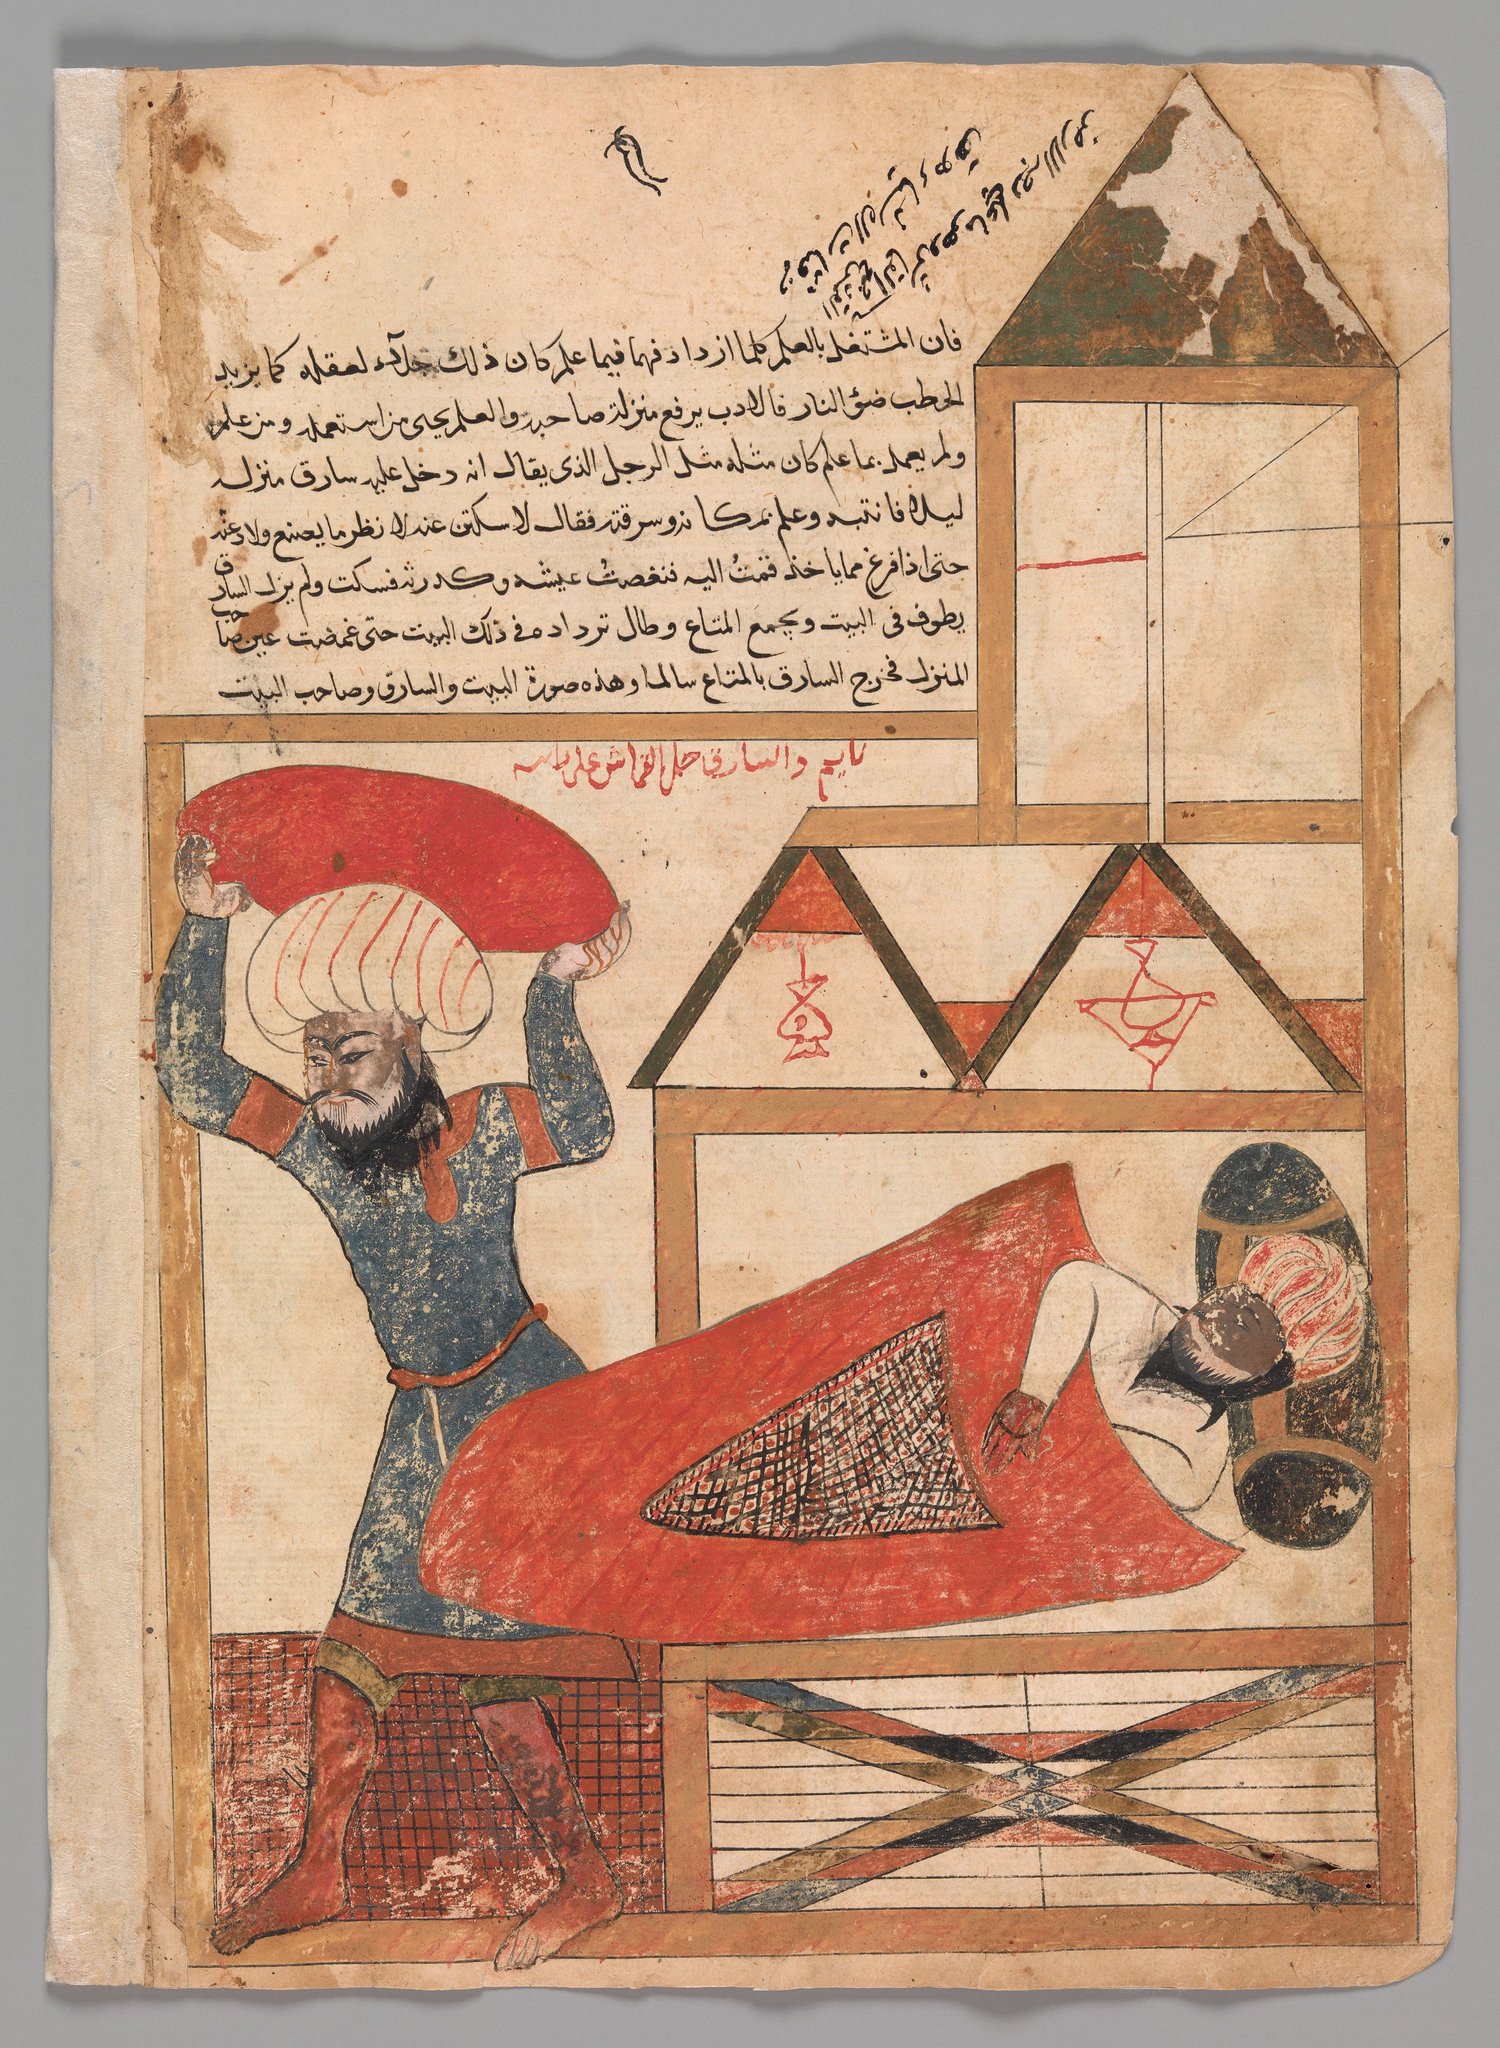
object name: folio from an illustrated manuscript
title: "The Man who Pretends to be Asleep While the Thief Enters his House Becomes Drowsy and Really Falls Asleep", Folio from a Kalila wa Dimna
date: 1526-1550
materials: paper, watercolor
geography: india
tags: sleeping,men